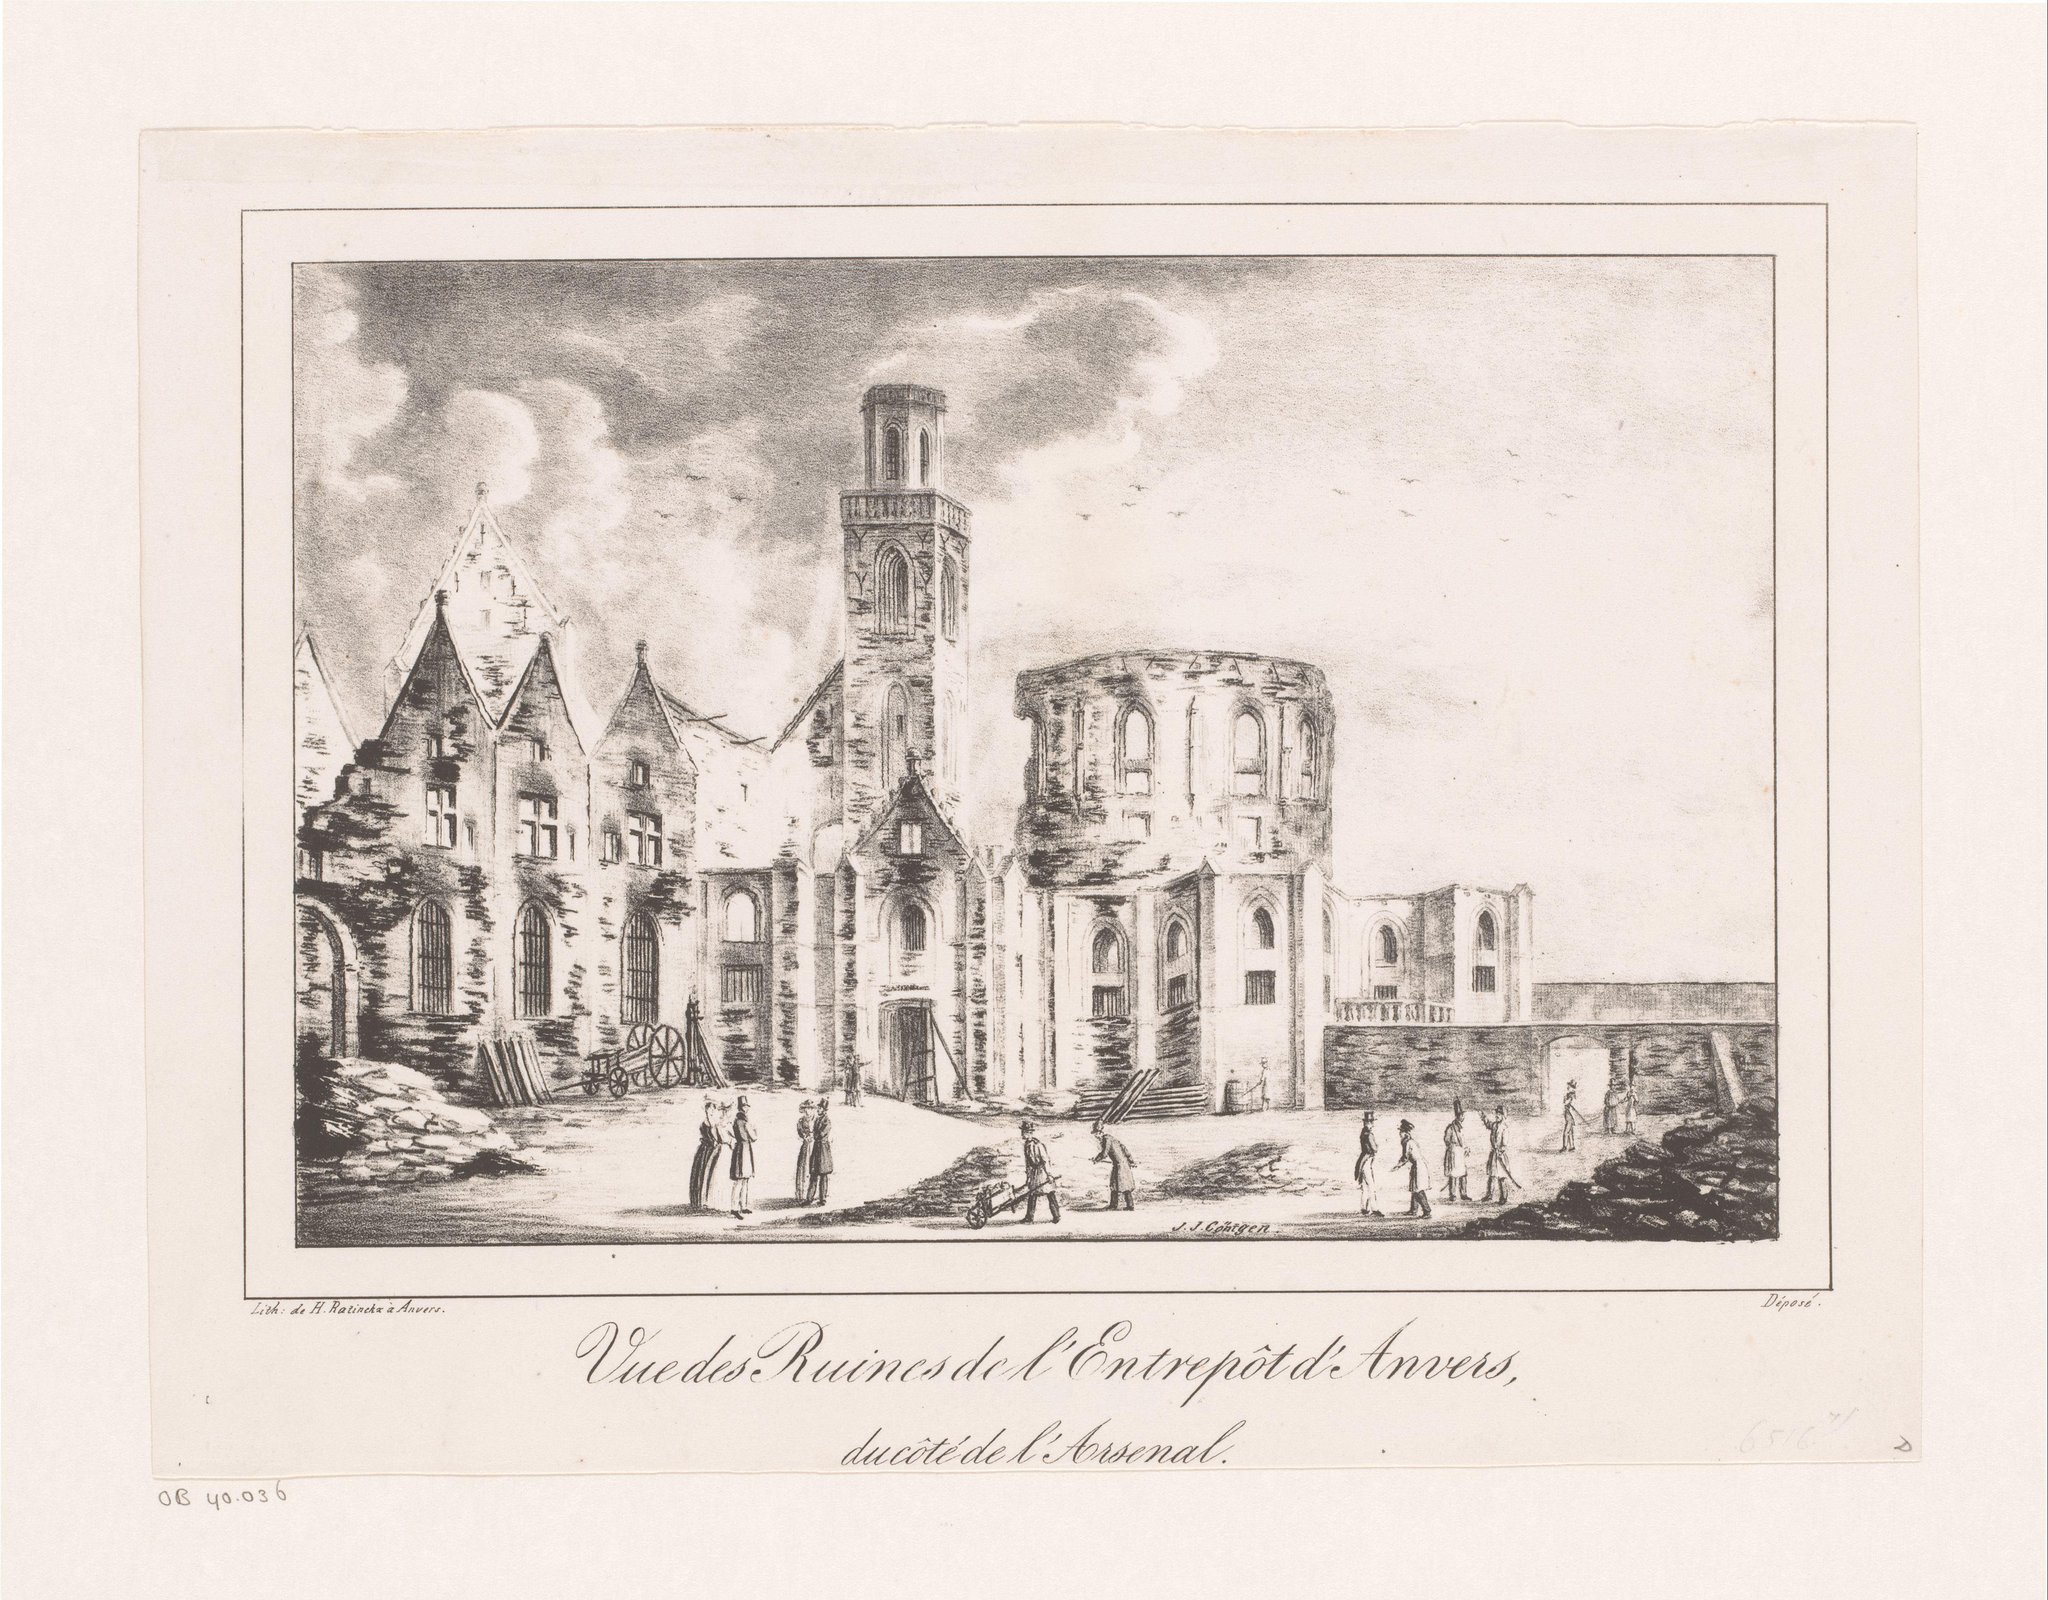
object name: print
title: Vue des ruines de l'Entrepôt d'Anvers, de côte de l'arsenal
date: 1830-1831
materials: paper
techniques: lithograph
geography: antwerp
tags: devastated, ruined place or city (~ warfare), antwerp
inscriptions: : ‘Déposé’, collector's mark: Lugt 2228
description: Onder FMH 6516 beschrijft Müller een serie van acht platen over de gebeurtenissen te Antwerpen van 26-27 oktober 1830, gedrukt bij Ratinckx te Antwerpen. In het Supplement worden onder het nummer 6516A nog eens negen platen vermeld die waarschijnlijk tot dezelfde serie behoren. Daarnaast bezit het RPK nog twee platen die waarschijnlijk tot dezelfde reeks behoren. Hier worden deze negentien platen beschreven als deel uit makend van één en dezelfde serie.